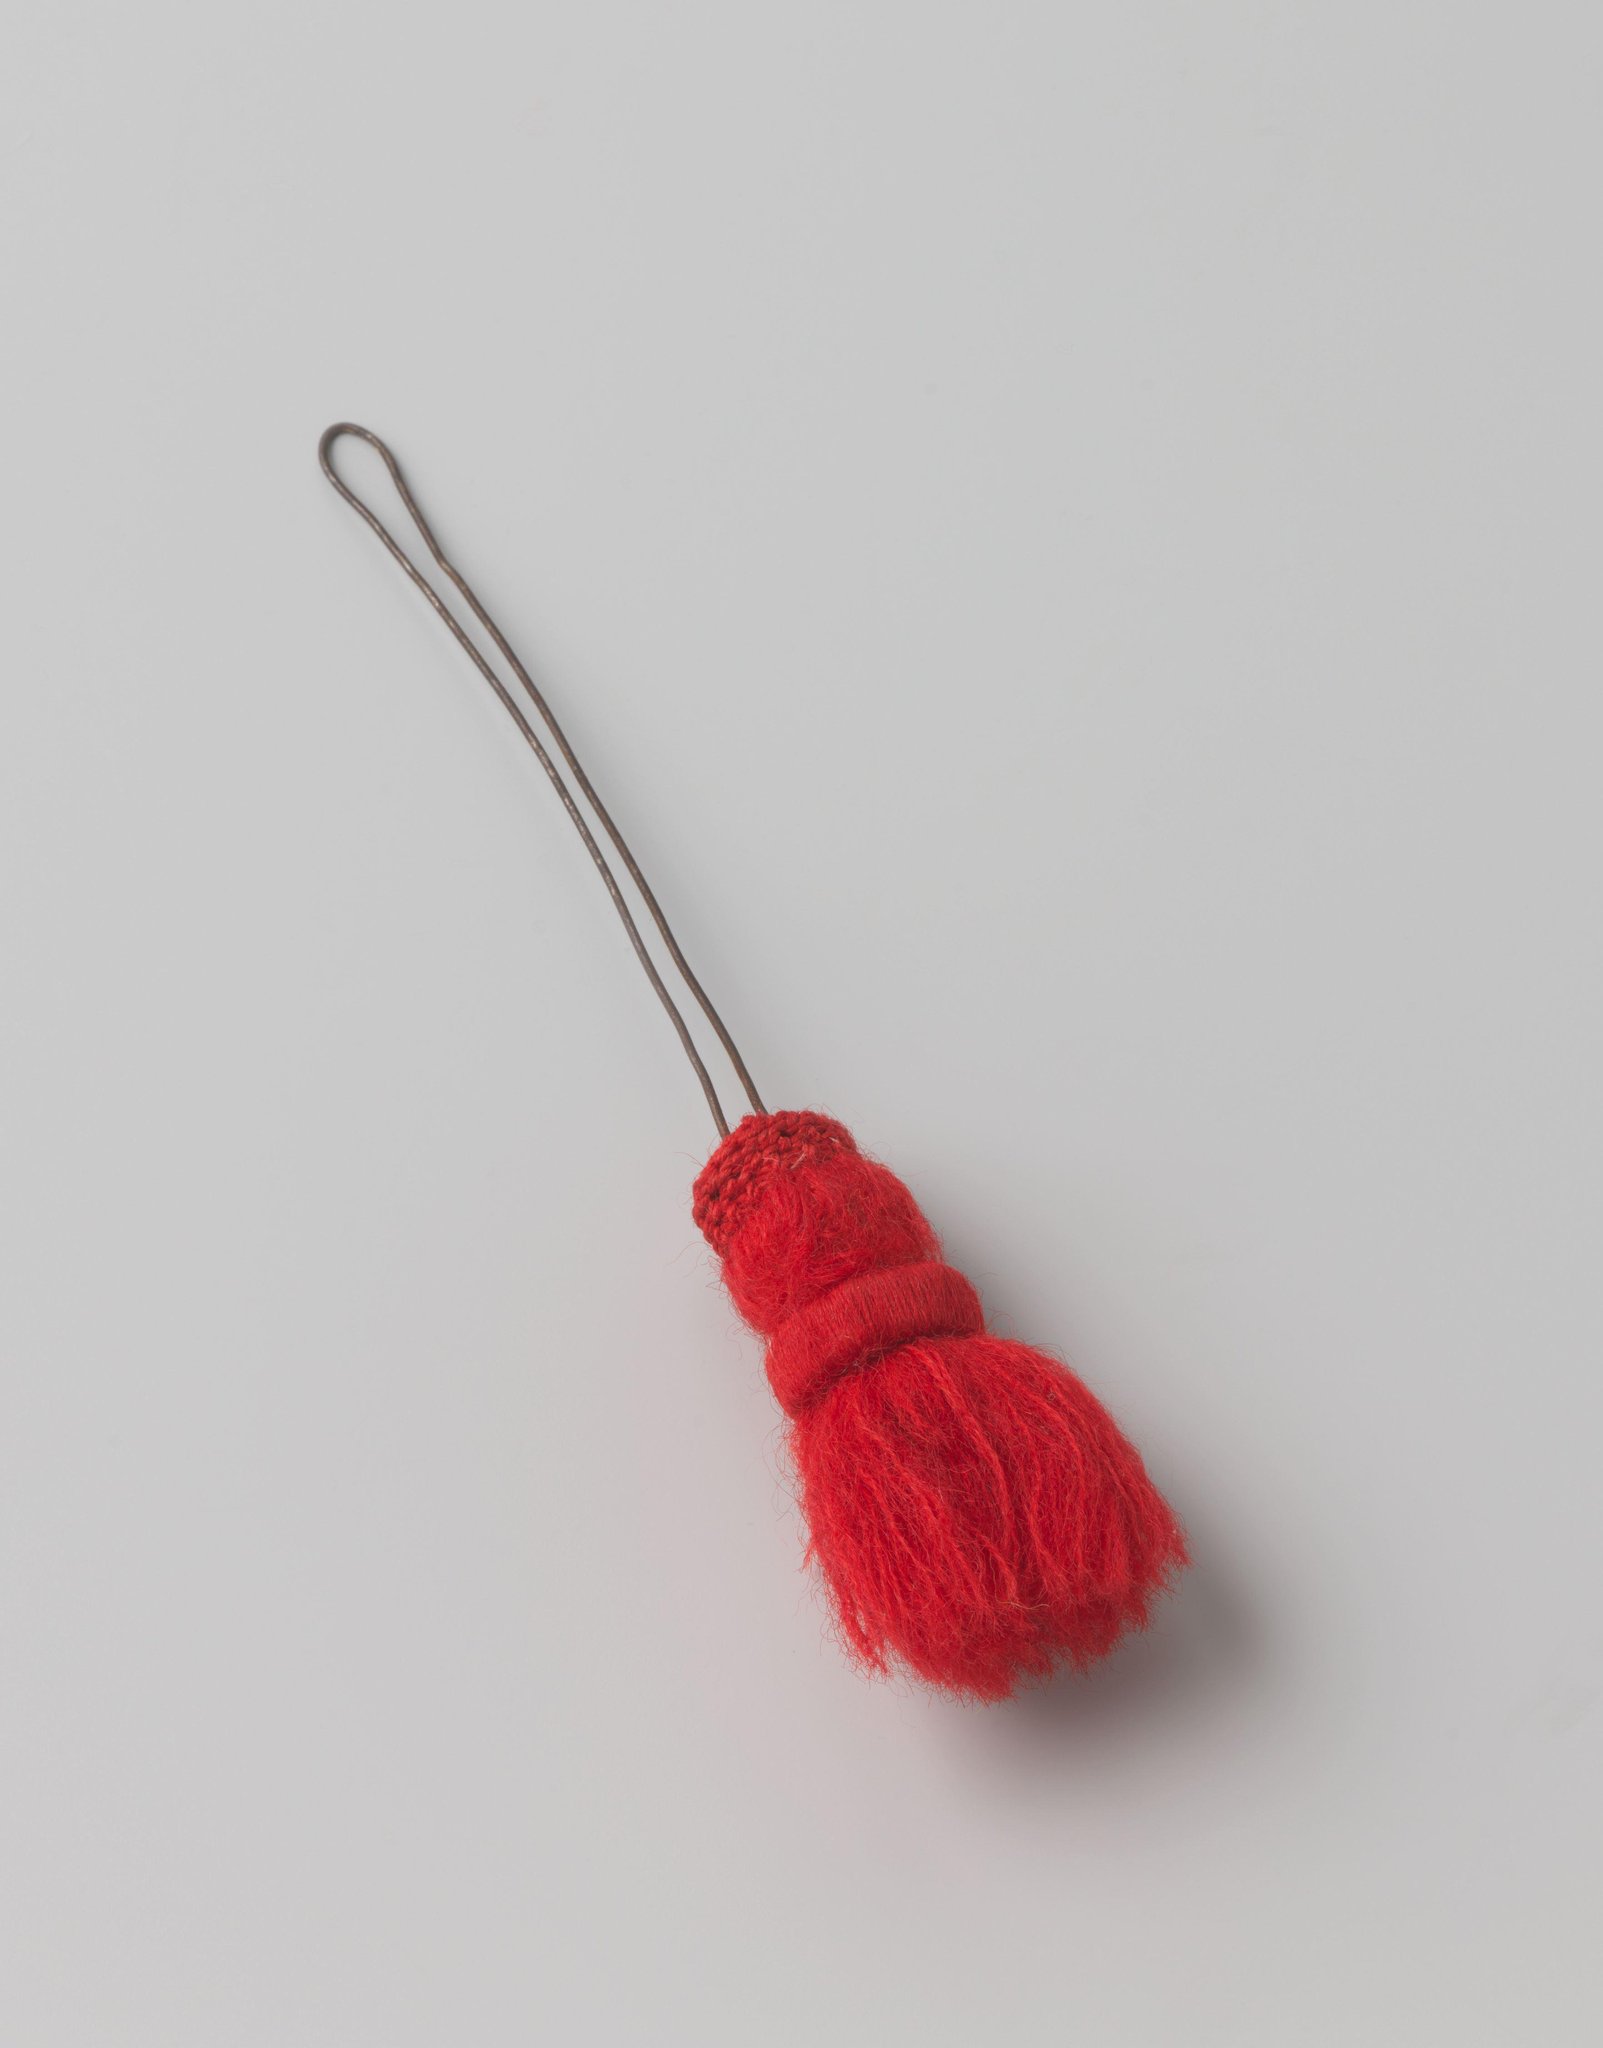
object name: plume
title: Vlam (pluim) voor sjako M. 1828 voor flankeurs der dienstdoende schutterij (1830-1839) of voor sjako van de garde nationale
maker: Anonymous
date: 1813-1839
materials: metal, wool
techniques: stitching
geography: netherlands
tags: netherlands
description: Pluim van rode wol, gezet op wit metalen draad. "Korf" van rode wol, waarop een dito kleurige pluim, waaromheen een rode wollen ring.